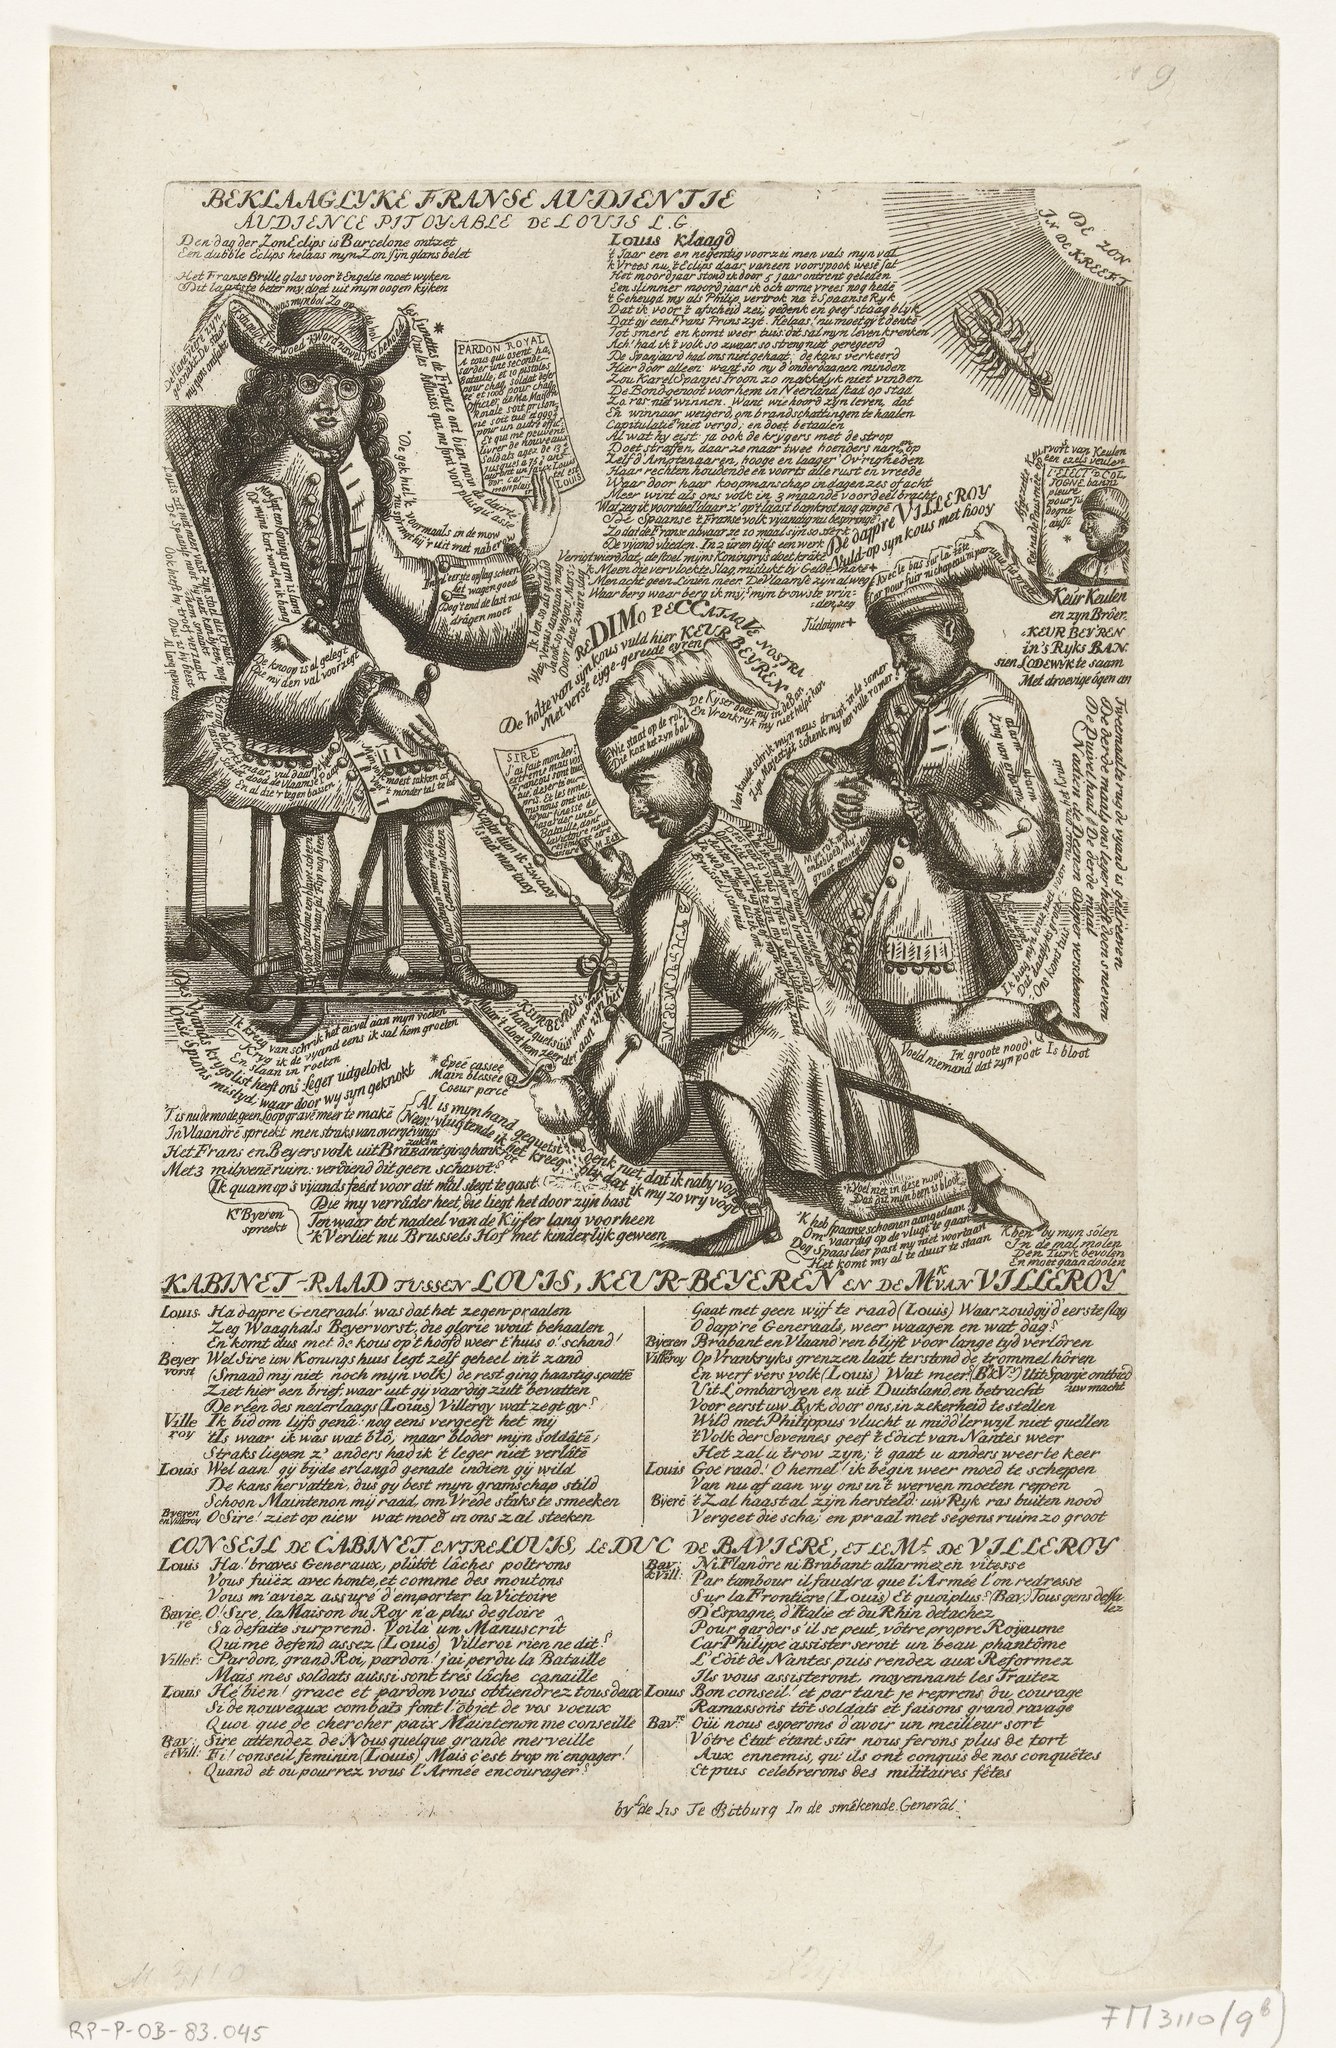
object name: cartoon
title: Villeroy en de keurvorst van Beieren knielen voor Lodewijk XIV, 1706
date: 1706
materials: paper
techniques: etching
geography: northern netherlands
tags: lodewijk xiv (koning van frankrijk), paris, françois de neufville (hertog van villeroy), maximiliaan ii emanuel (keurvorst van beieren), political caricatures and satires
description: De hertog van Villeroy en Maximiliaan II Emanuel, de keurvorst van Beieren, knielen met de kous op de kop voor koning Lodewijk XIV, 1706. In de plaat verzen in het Nederlands en Frans. Spotprent op de situatie in het jaar 1706 in de Spaanse Successieoorlog. Onderdeel van een reeks van 25 spotprenten op de Fransen en bondgenoten uit het jaar 1706.